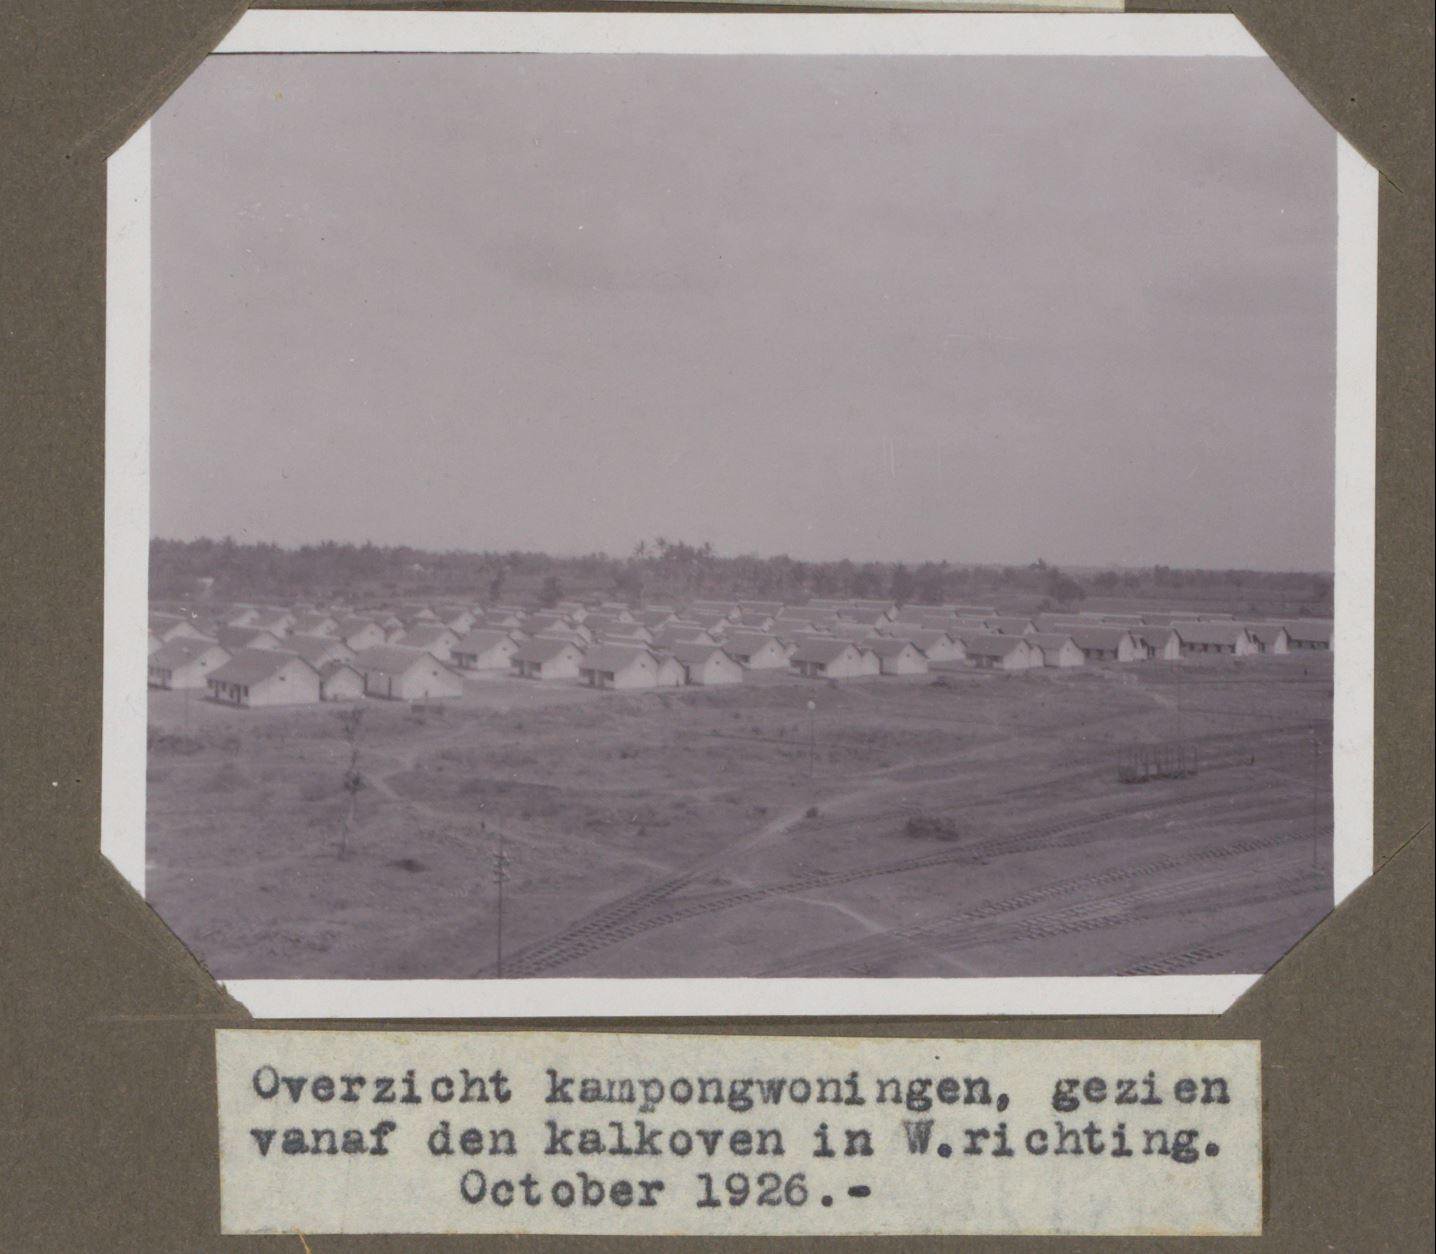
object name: photograph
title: Overzicht kampongwoningen, gezien vanaf den kalkoven in W. richting. October 1926.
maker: Anonymous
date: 1910-1926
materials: photographic support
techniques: gelatin silver print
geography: east java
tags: colonial system, trade-company, making the overground structures (~ building activities), (non-fruit) products of plants or trees: sugarcane, representation of real building (either existing or having existed)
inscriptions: inscription: ‘Overzicht kampongwoningen, gezien vanaf den kalkoven in W. richting. October 1926.’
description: Gezicht op de kampongwoningen op het fabrieksterrein, oktober 1926. Onderdeel van het fotoalbum met foto's van de opbouw van de suikerfabriek te Goenoengsari op Oost-Java door de Handels Vereniging Amsterdam 1926-1927.